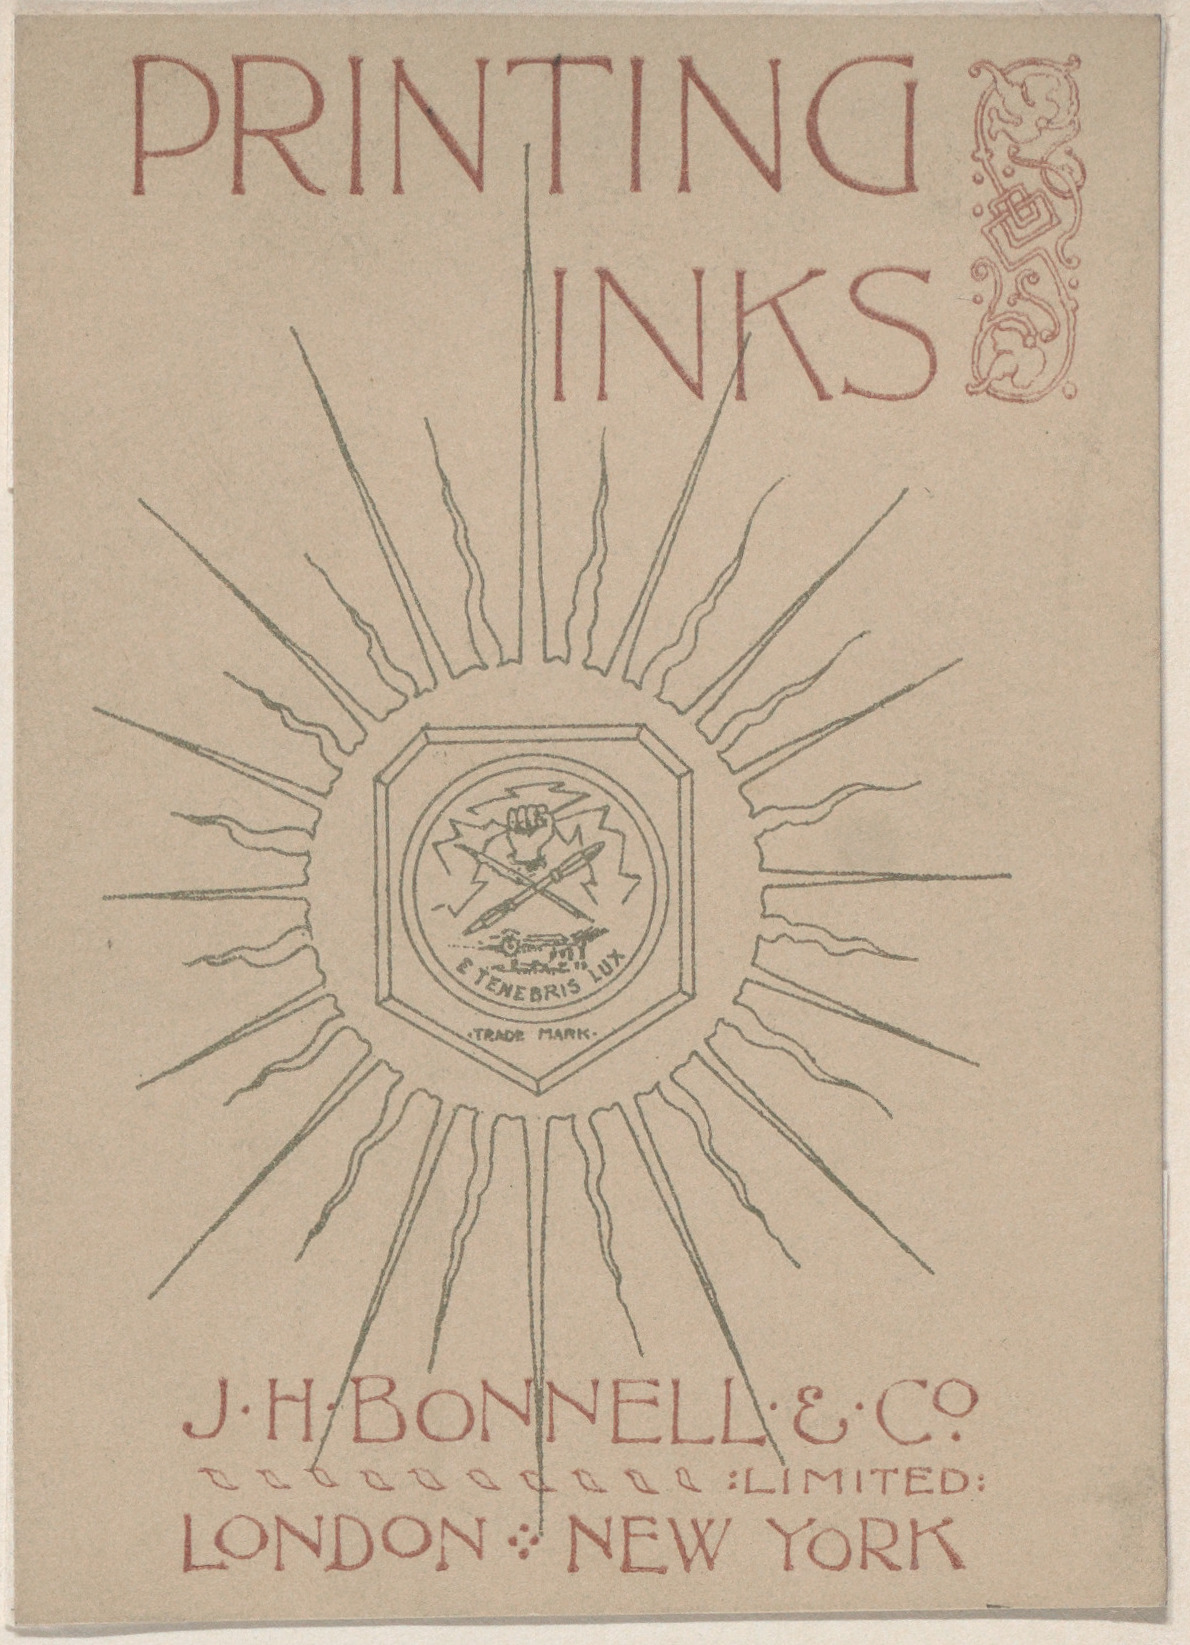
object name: print, trade card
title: Trade Card for J. H. Bonnell & Co., Print Ink Seller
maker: anonymous, british, 19th century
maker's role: artist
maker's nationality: british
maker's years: 1800-1900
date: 1801-1900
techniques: lithograph